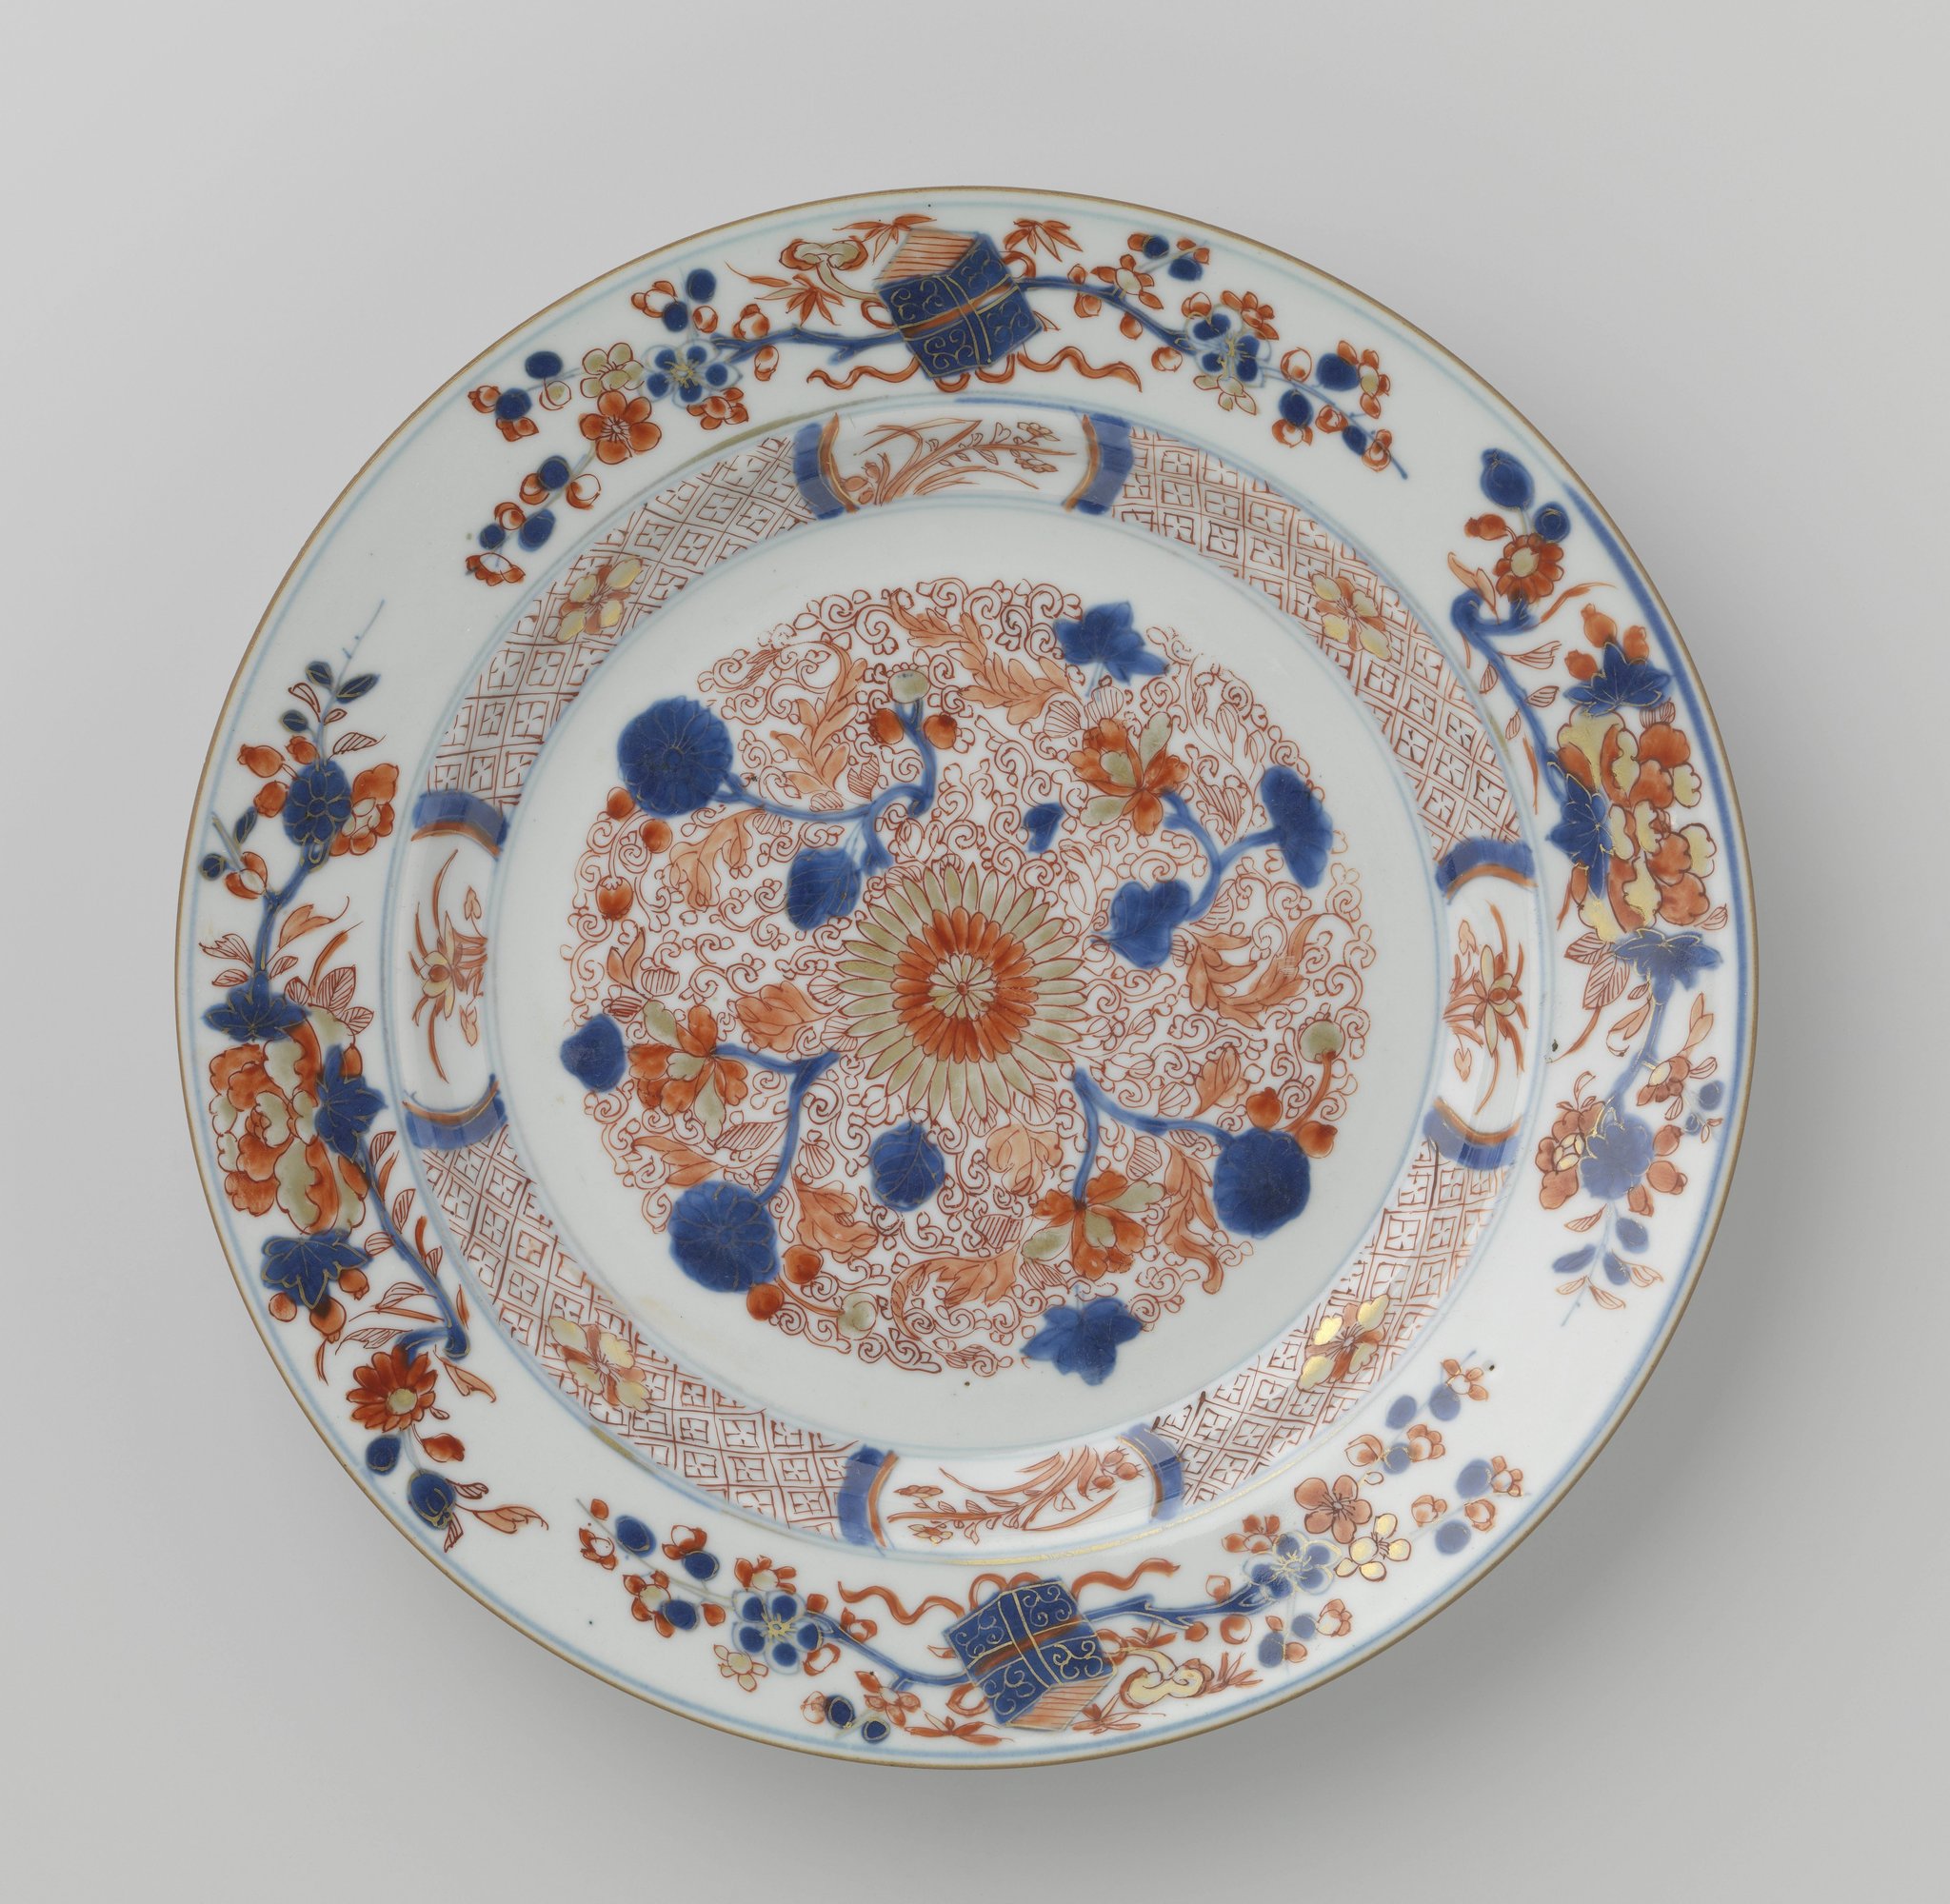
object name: platter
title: Dish with lotus scrolls, flowering plants and flower sprays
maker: Anonymous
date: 1700-1724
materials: cobalt, glaze, gold, paint, porcelain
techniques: firing, gilding, turning, vitrification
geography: china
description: Schotel van porselein, beschilderd in onderglazuur blauw en op het glazuur rood en goud. Op het plat een rozet van lotusranken, De wand met een band servetwerk met een bloem onderbroken door bloeiende planten (lotus) in een cartouche. Op de wand twee pioentakken en twee prunustakken met een boek. Chinees Imari.